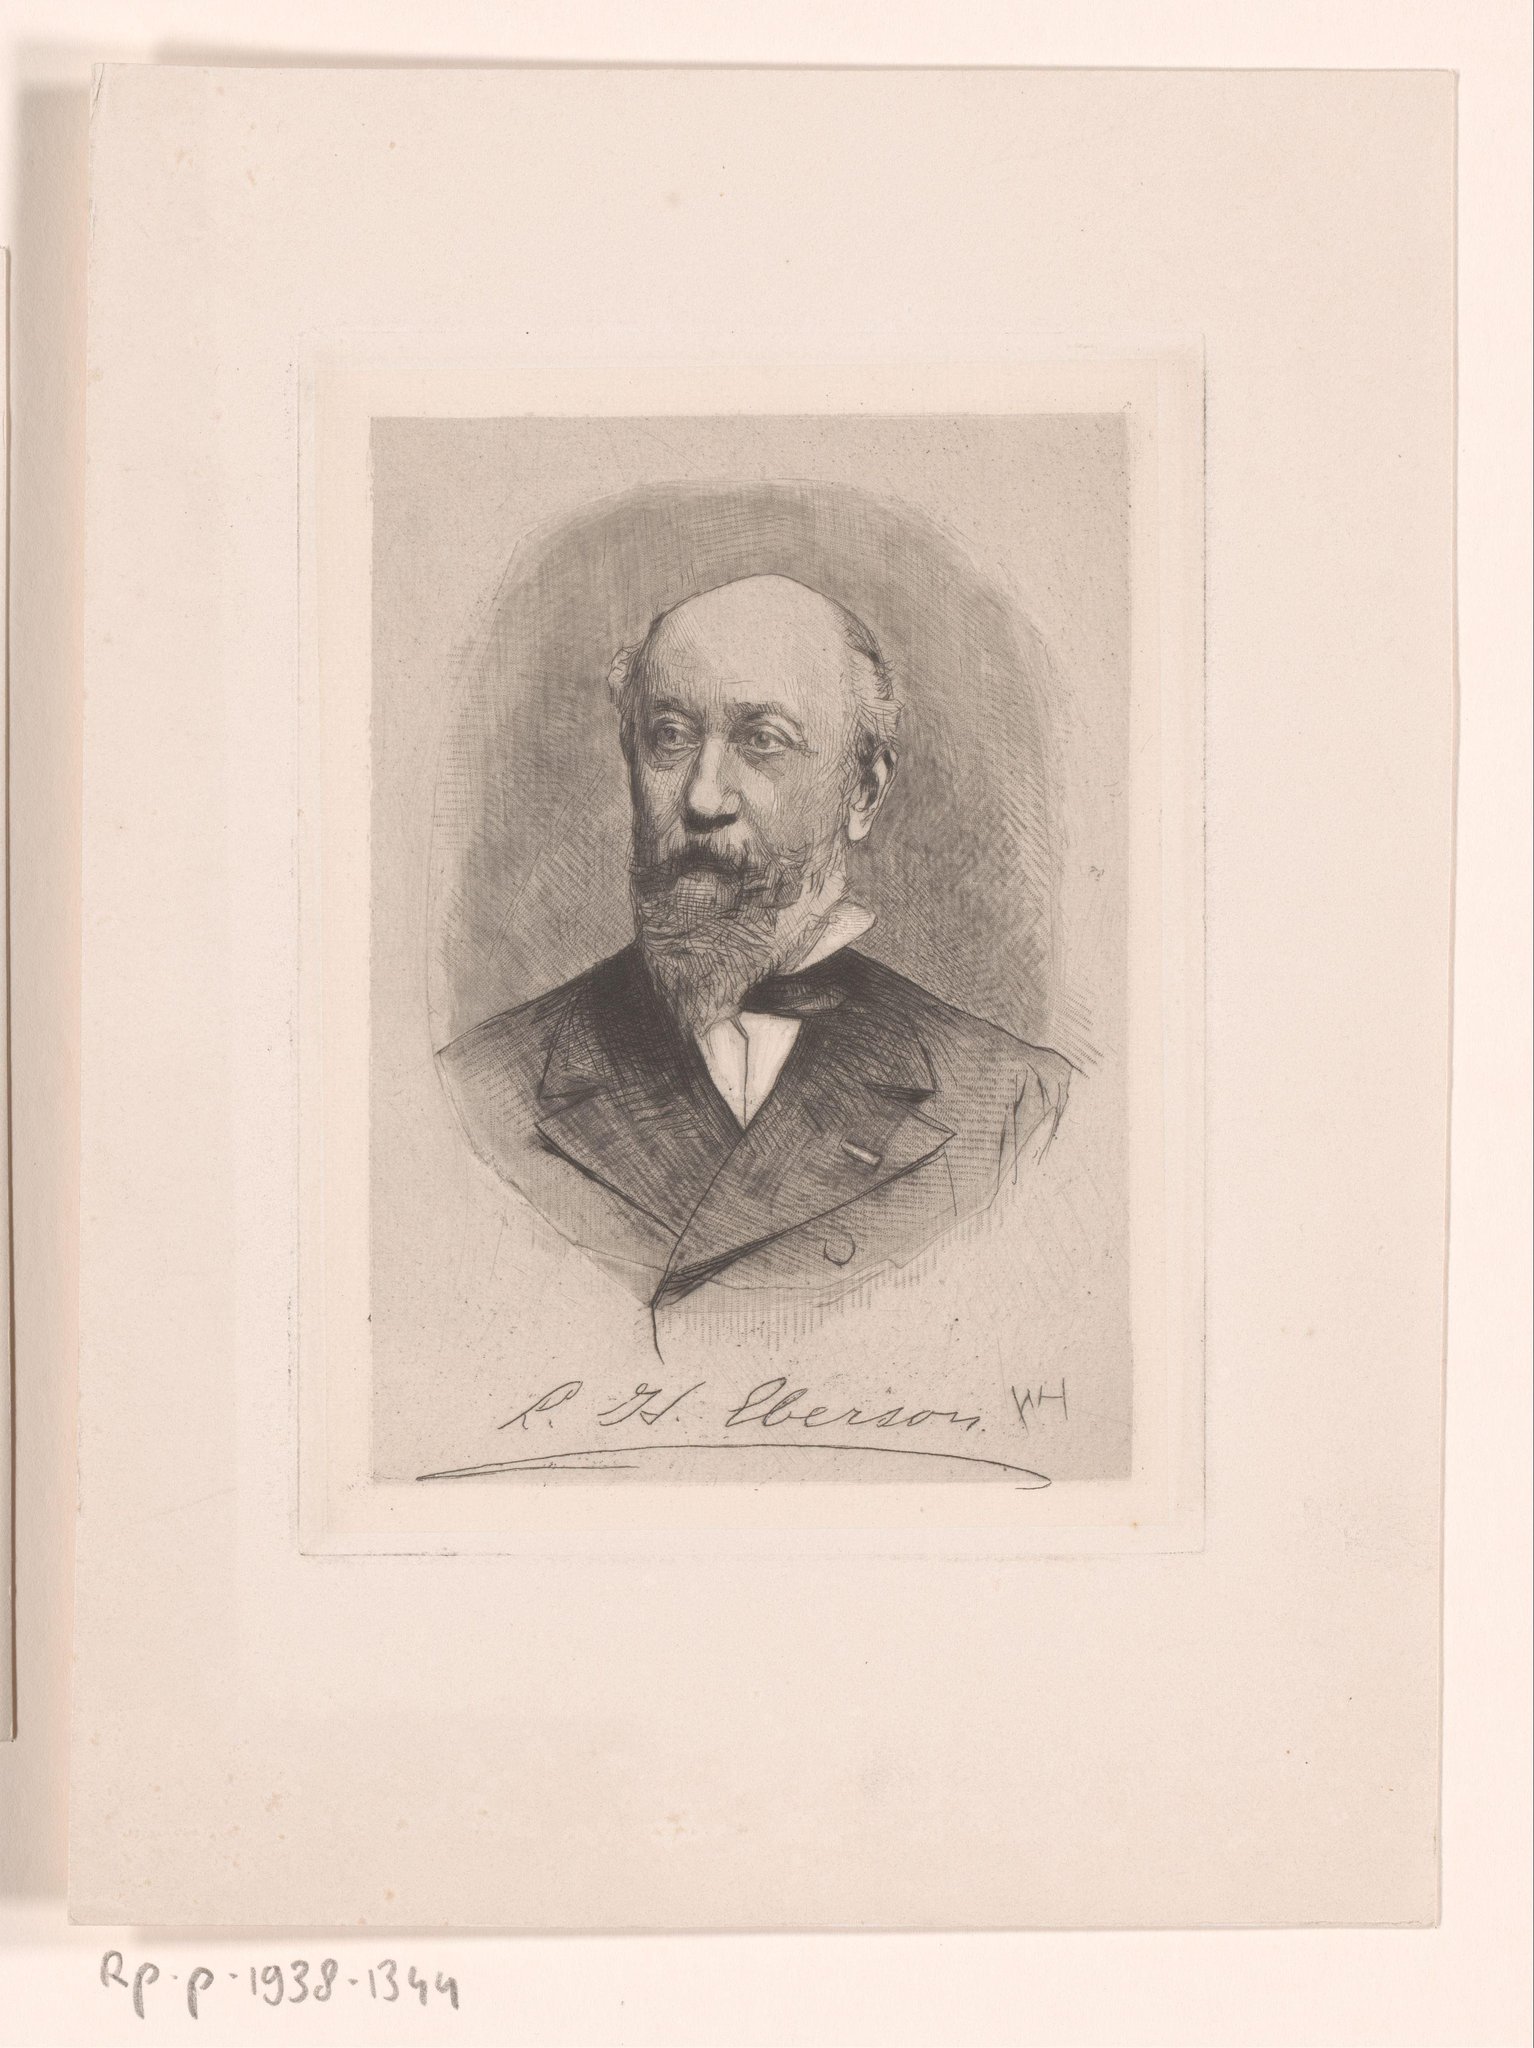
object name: print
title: Portret van Lucas Hermanus Eberson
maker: henri wouters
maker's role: draughtsman, print maker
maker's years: 1866-1935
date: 1876-1891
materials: paper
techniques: drypoint, etching, intaglio, roulette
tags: arnhem, draughtsman, lucas hermanus eberson, portrait, self-portrait of architect, historical persons (portraits and scenes from the life)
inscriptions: collector's mark: Lugt 2228, collector's mark: Lugt 2760